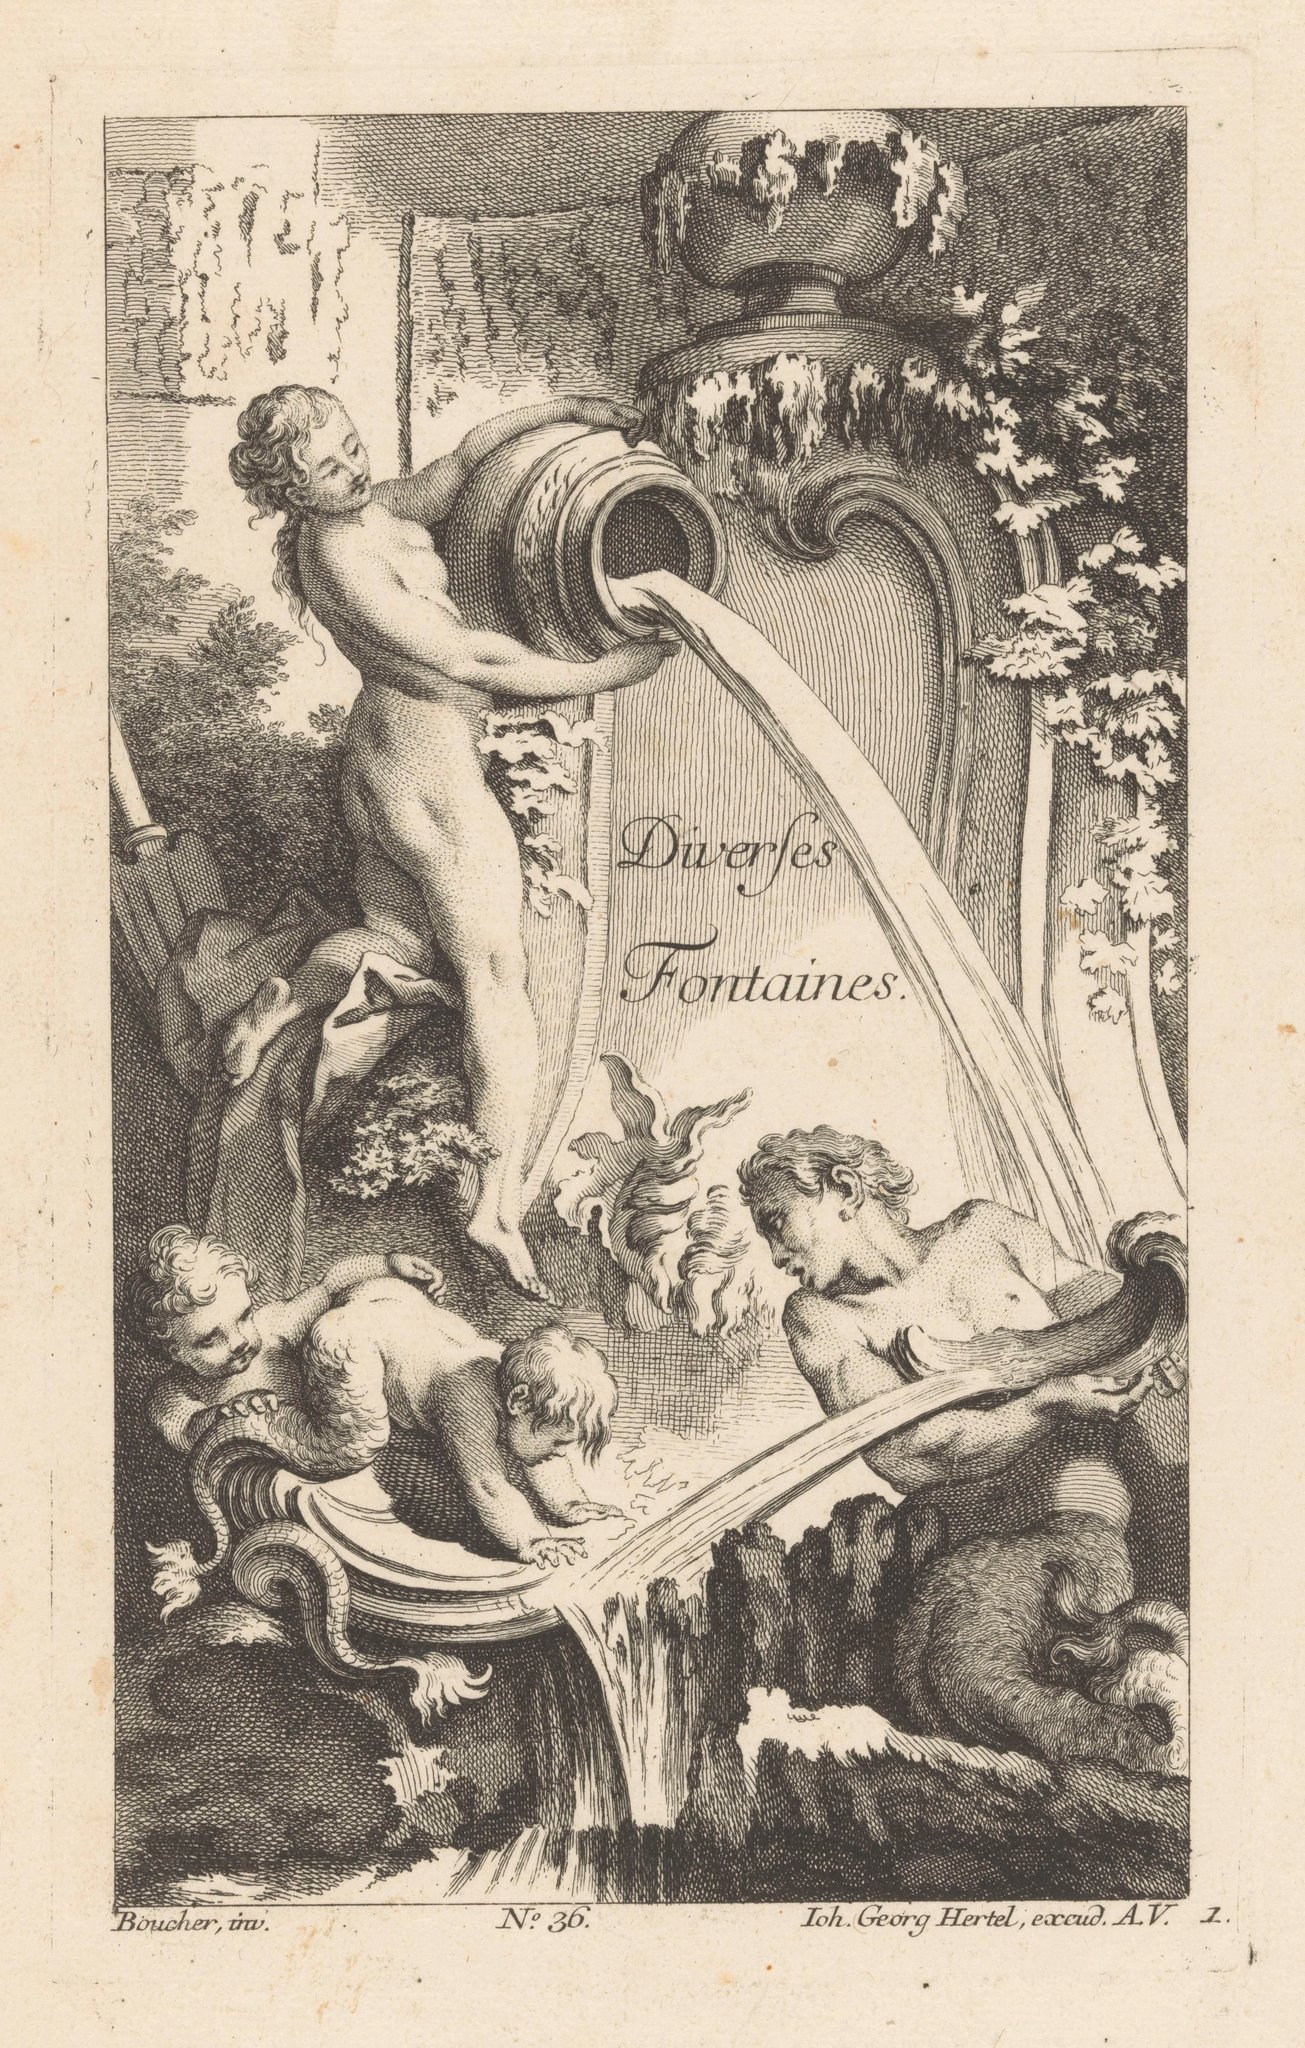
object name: ornament print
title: Fontein met vrouw, meerman en kinderen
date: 1713-1760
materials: paper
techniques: etching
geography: augsburg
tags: merman, monsters ~ fishes, standing figure - aa - female human figure, ornamental fountain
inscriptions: collector's mark: Lugt 2760, collector's mark: Lugt 2228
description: Links houdt een staande vrouw een kruik vast waaruit water stroomt richting een schelp vastgehouden door een meerman rechts onder. Links zitten twee kinderen met vissenstaarten. Uitgeversnummer 36.